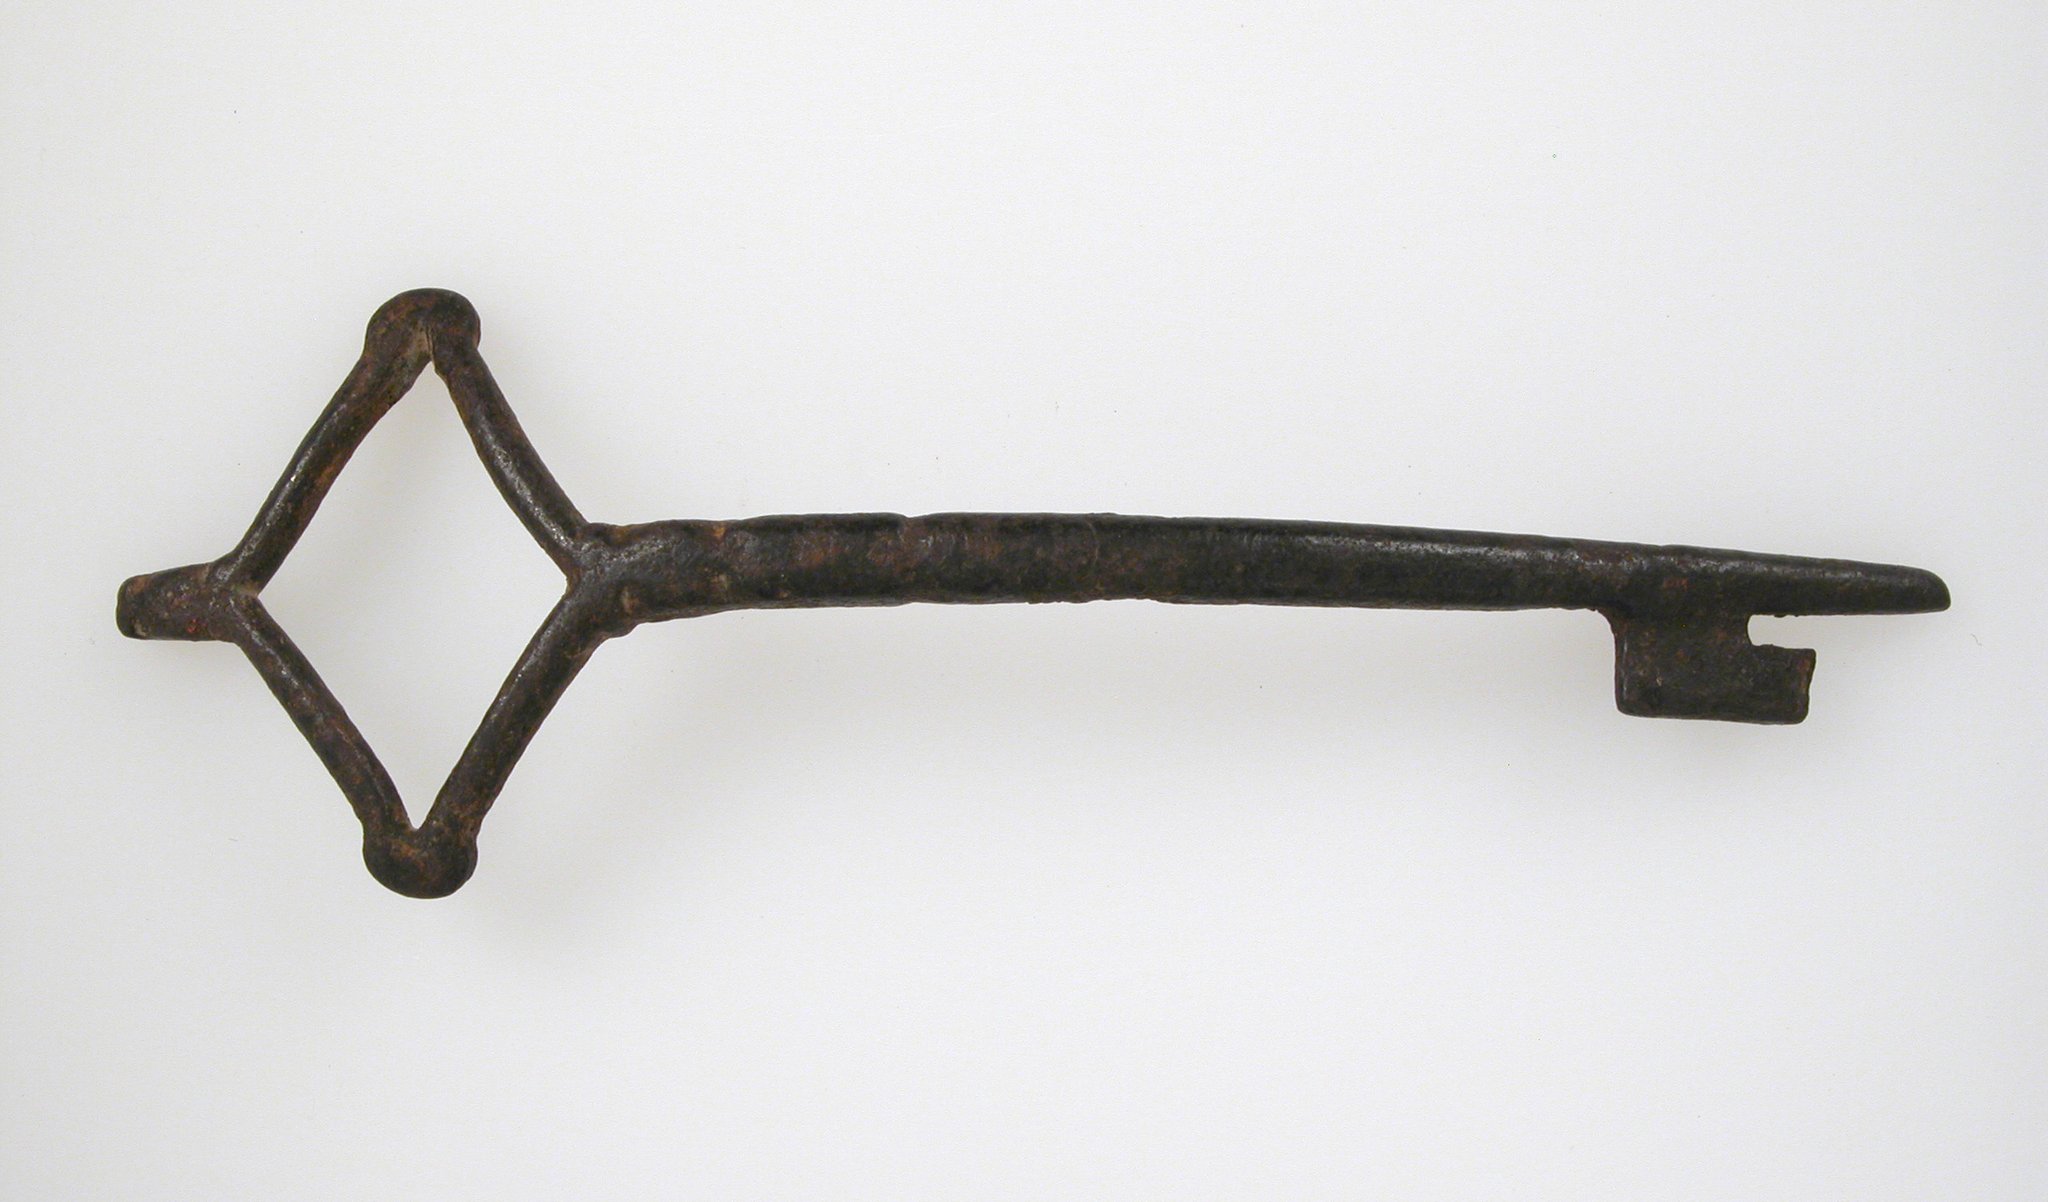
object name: key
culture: german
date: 1201-1300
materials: iron